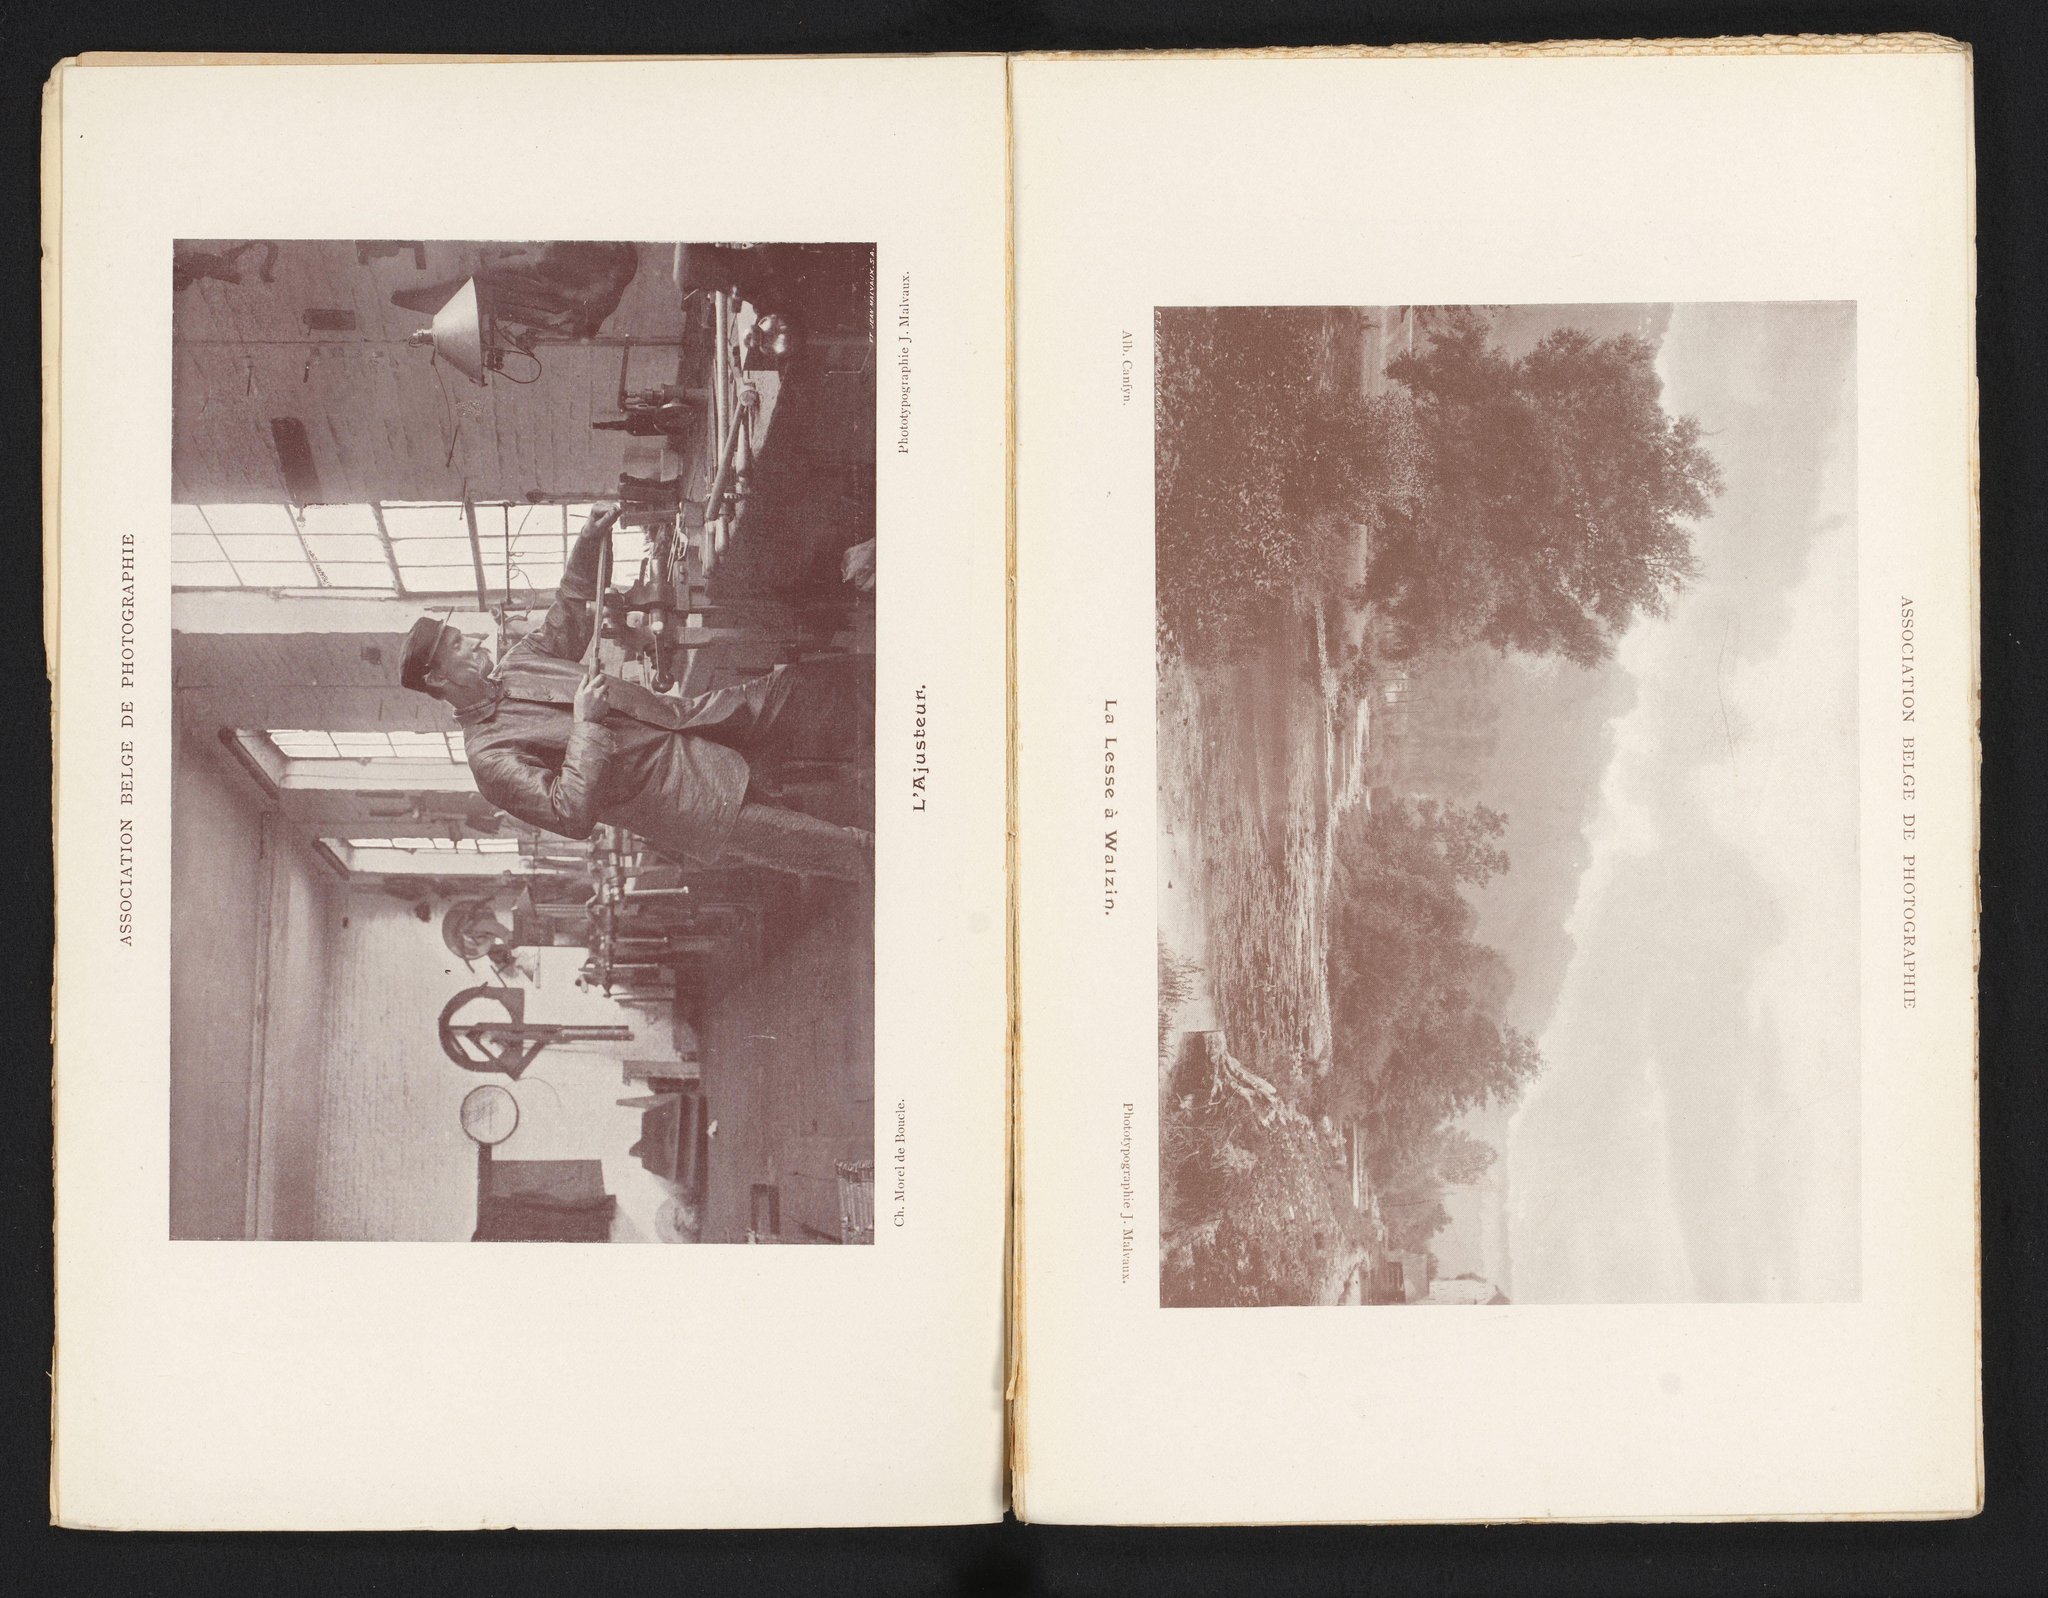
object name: page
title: L'Ajusteur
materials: paper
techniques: autotype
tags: workshop-interior (+ men (labourers))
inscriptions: inscription: ‘ASSOCIATION BELGE DE PHOTOGRAPHIE’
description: Prent op tweede ongenummerde pagina na pagina XVI.